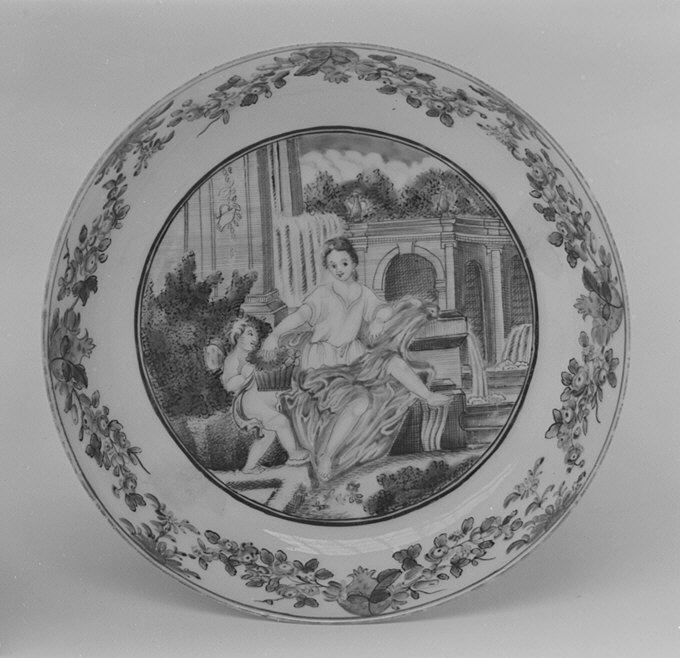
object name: saucer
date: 1750-1770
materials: hard paste porcelain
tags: boys,women